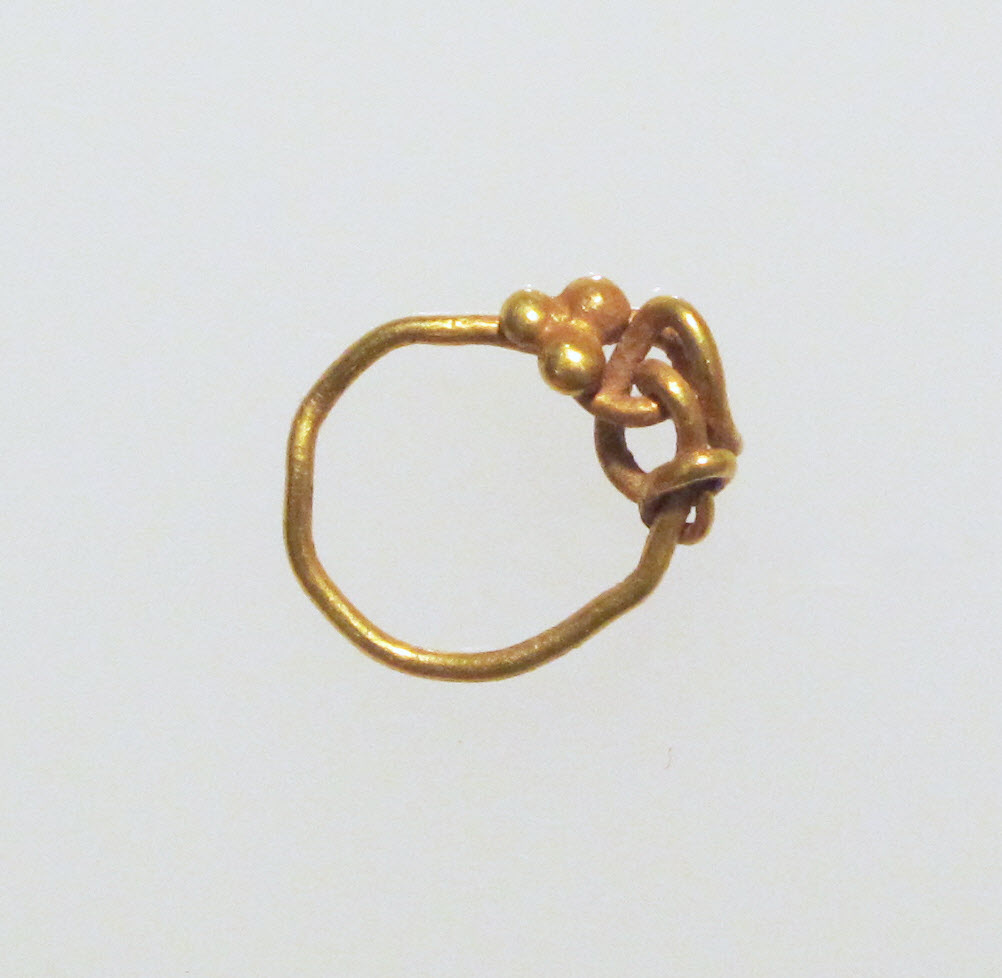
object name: earring loop type, plain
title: Earring-loop type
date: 7000 BCE-330 CE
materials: gold